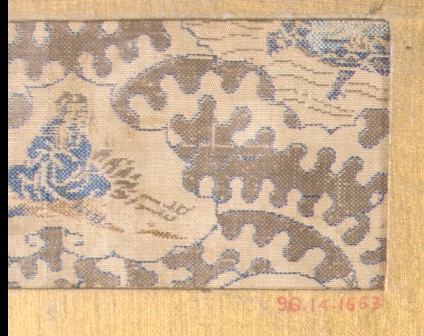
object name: piece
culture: japanese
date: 1701-1900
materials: silk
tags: human figures